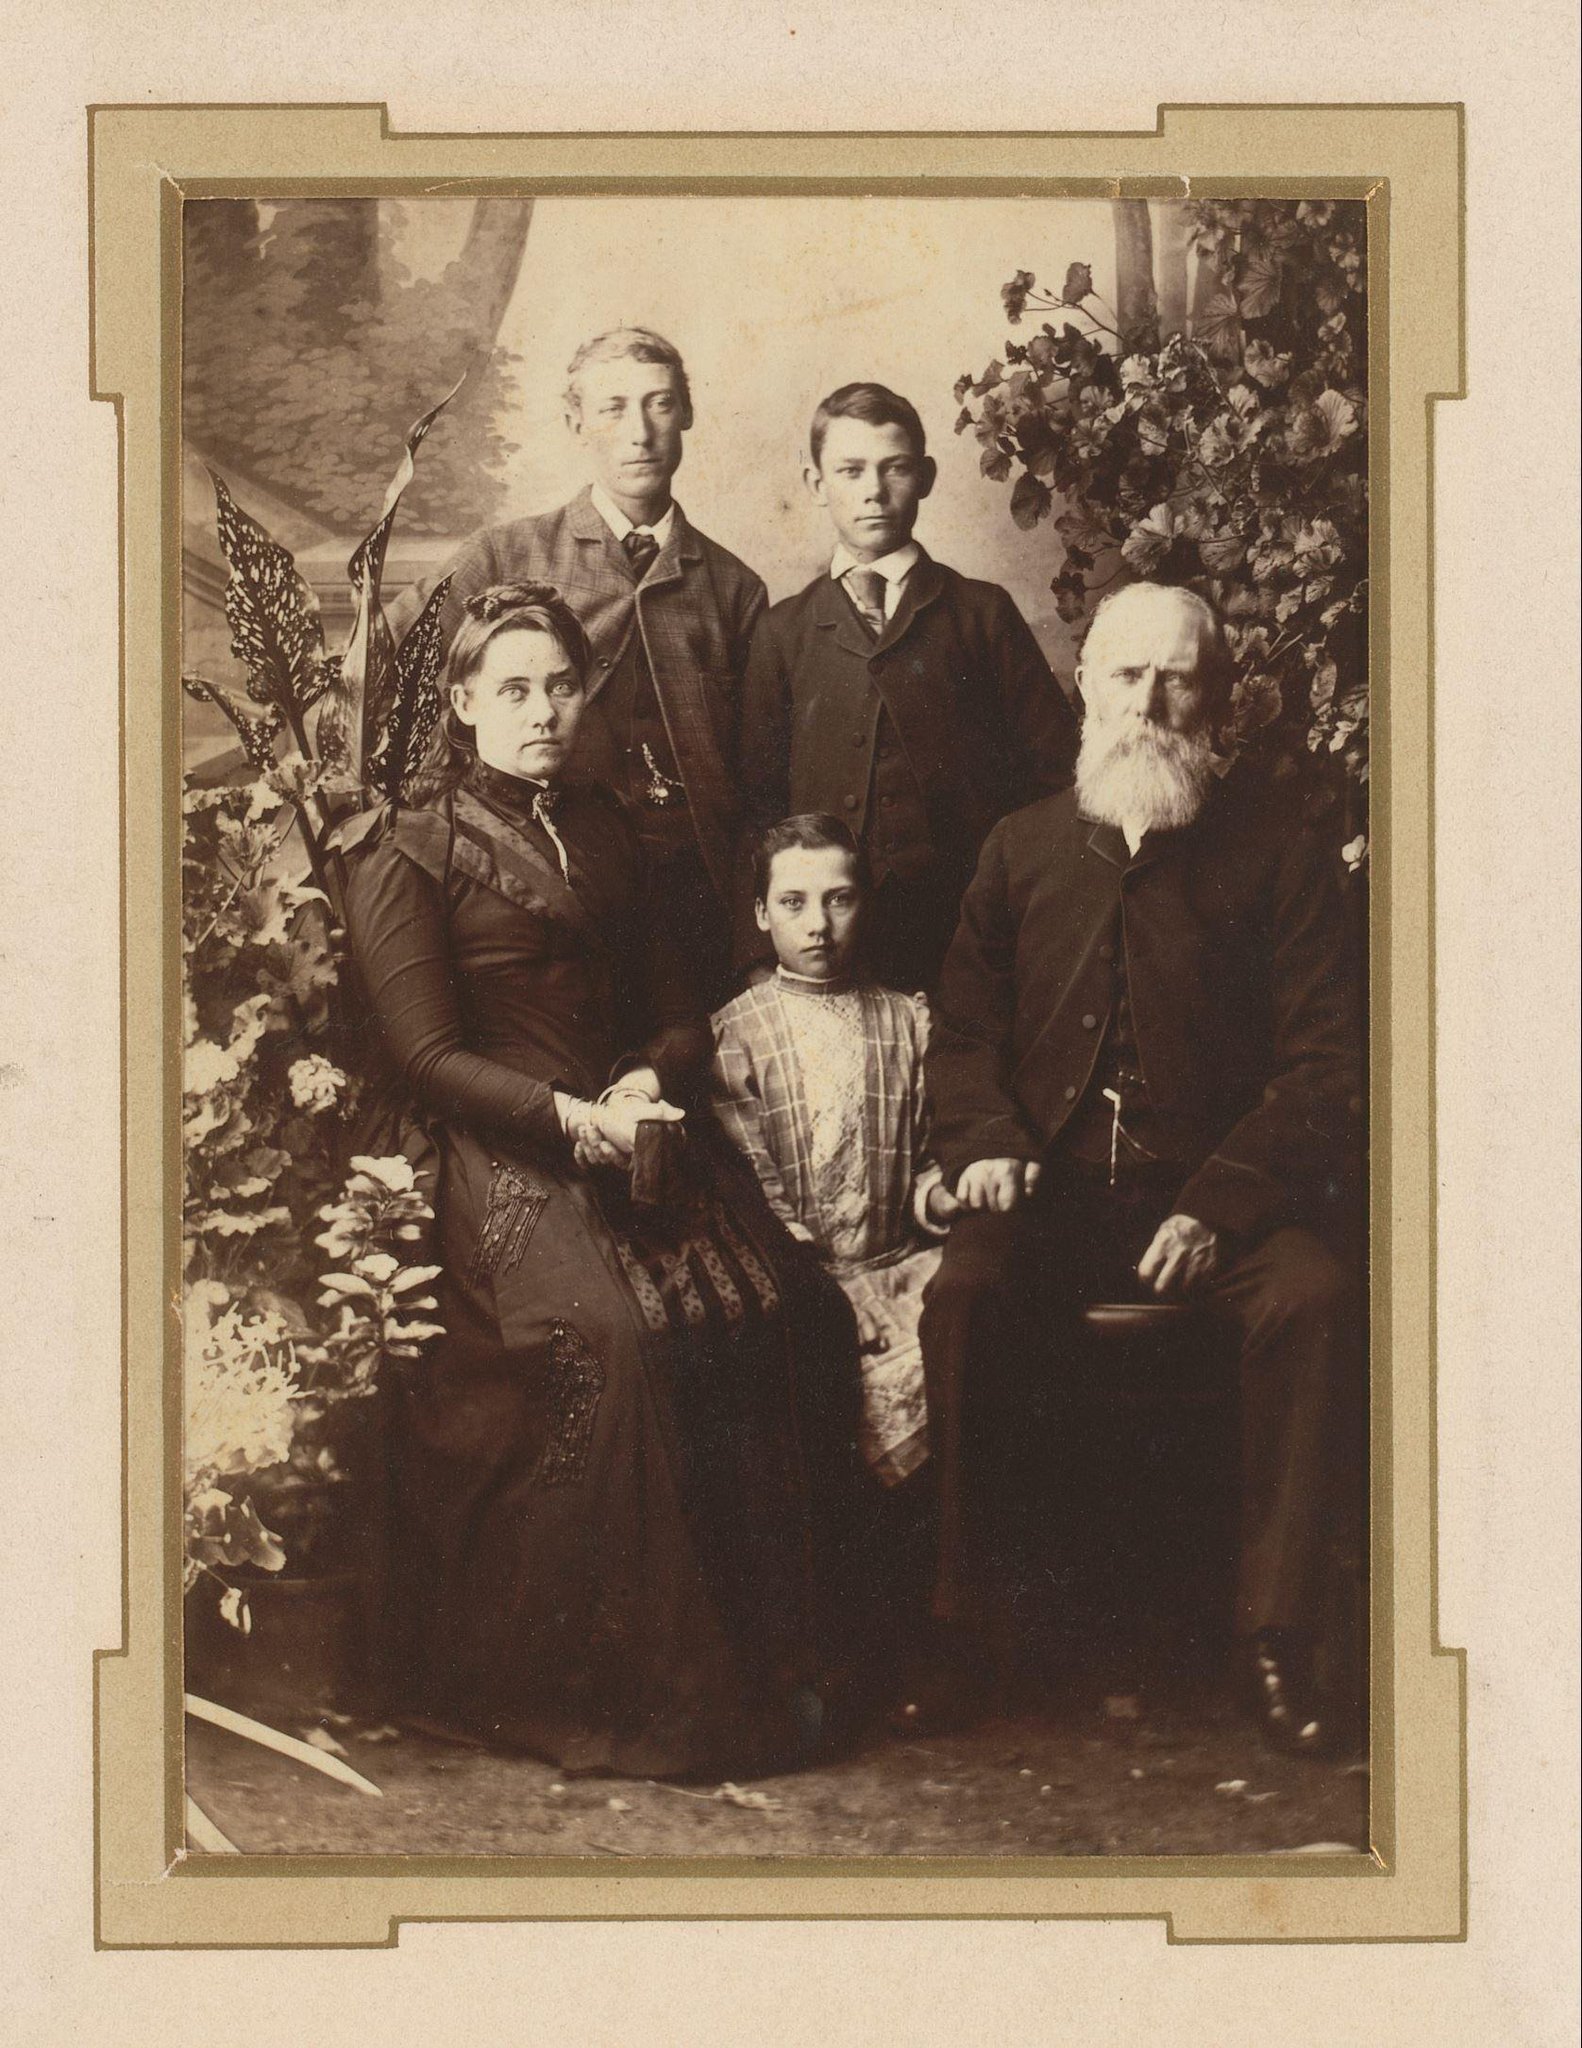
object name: photograph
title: Familieportret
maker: a.j. hochapfel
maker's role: fotograaf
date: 1870-1900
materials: cardboard, photographic support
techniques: albumen print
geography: orange free state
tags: family group, especially parents with their child(ren)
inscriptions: inscription: ‘From the Studio of/ A.J. Hochapfel/ Photographer/ Orange Free State (...)’